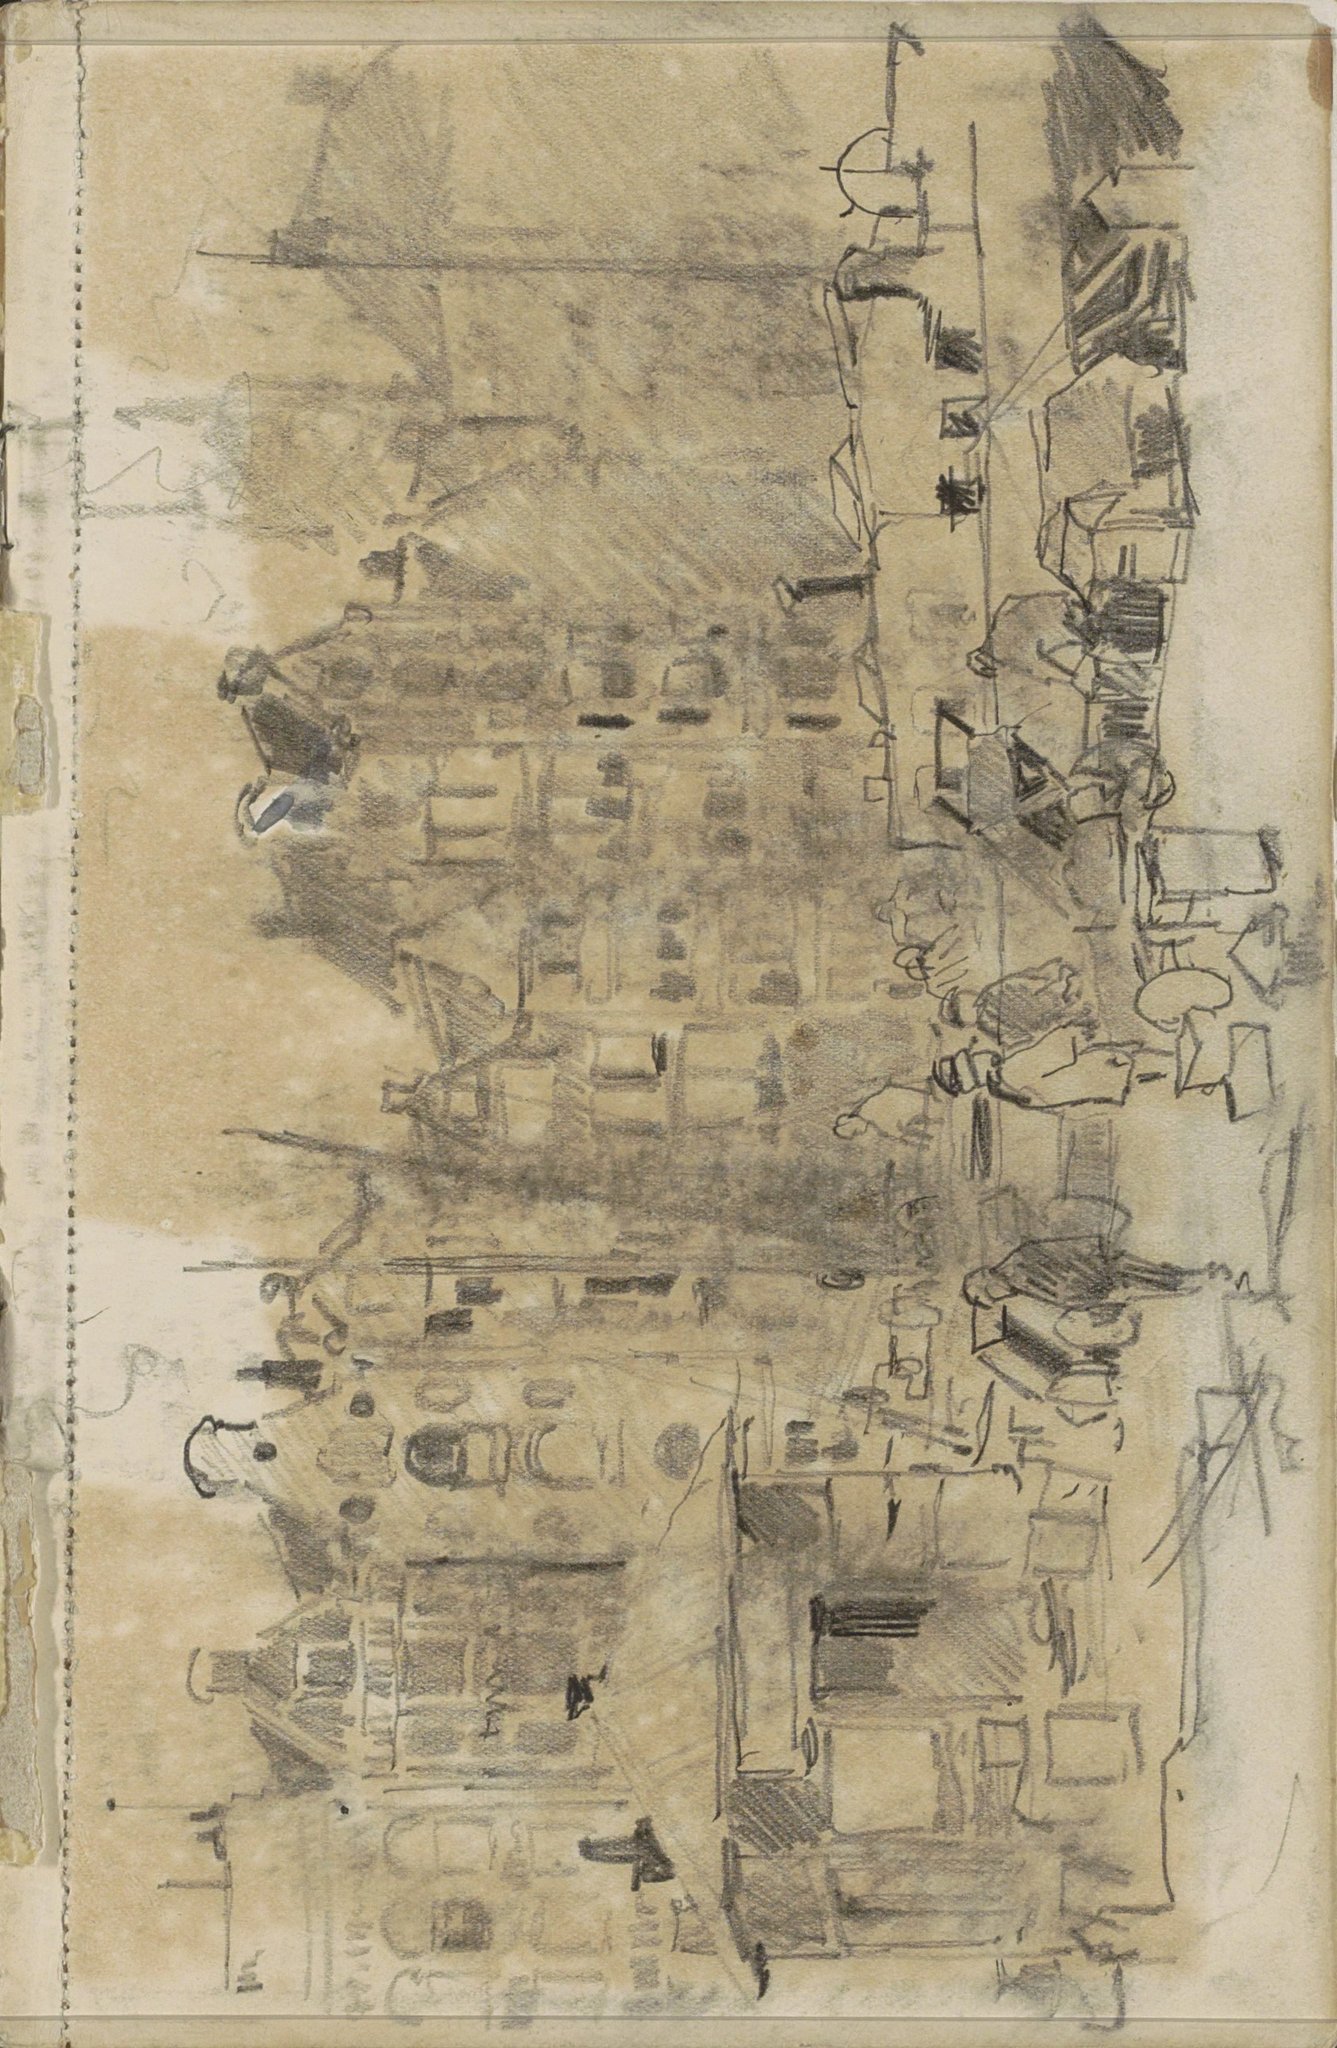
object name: sketchbook leaf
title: Huizen aan een gracht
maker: cornelis vreedenburgh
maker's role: draughtsman, print maker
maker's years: 1880-1946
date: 1890-1946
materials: paper, pencil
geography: amsterdam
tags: canals, waters (in city), the usual house or row of houses, amsterdam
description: Mogelijk de Oude Turfmarkt te Amsterdam. Blad 1 recto uit een schetsboek met 59 bladen.